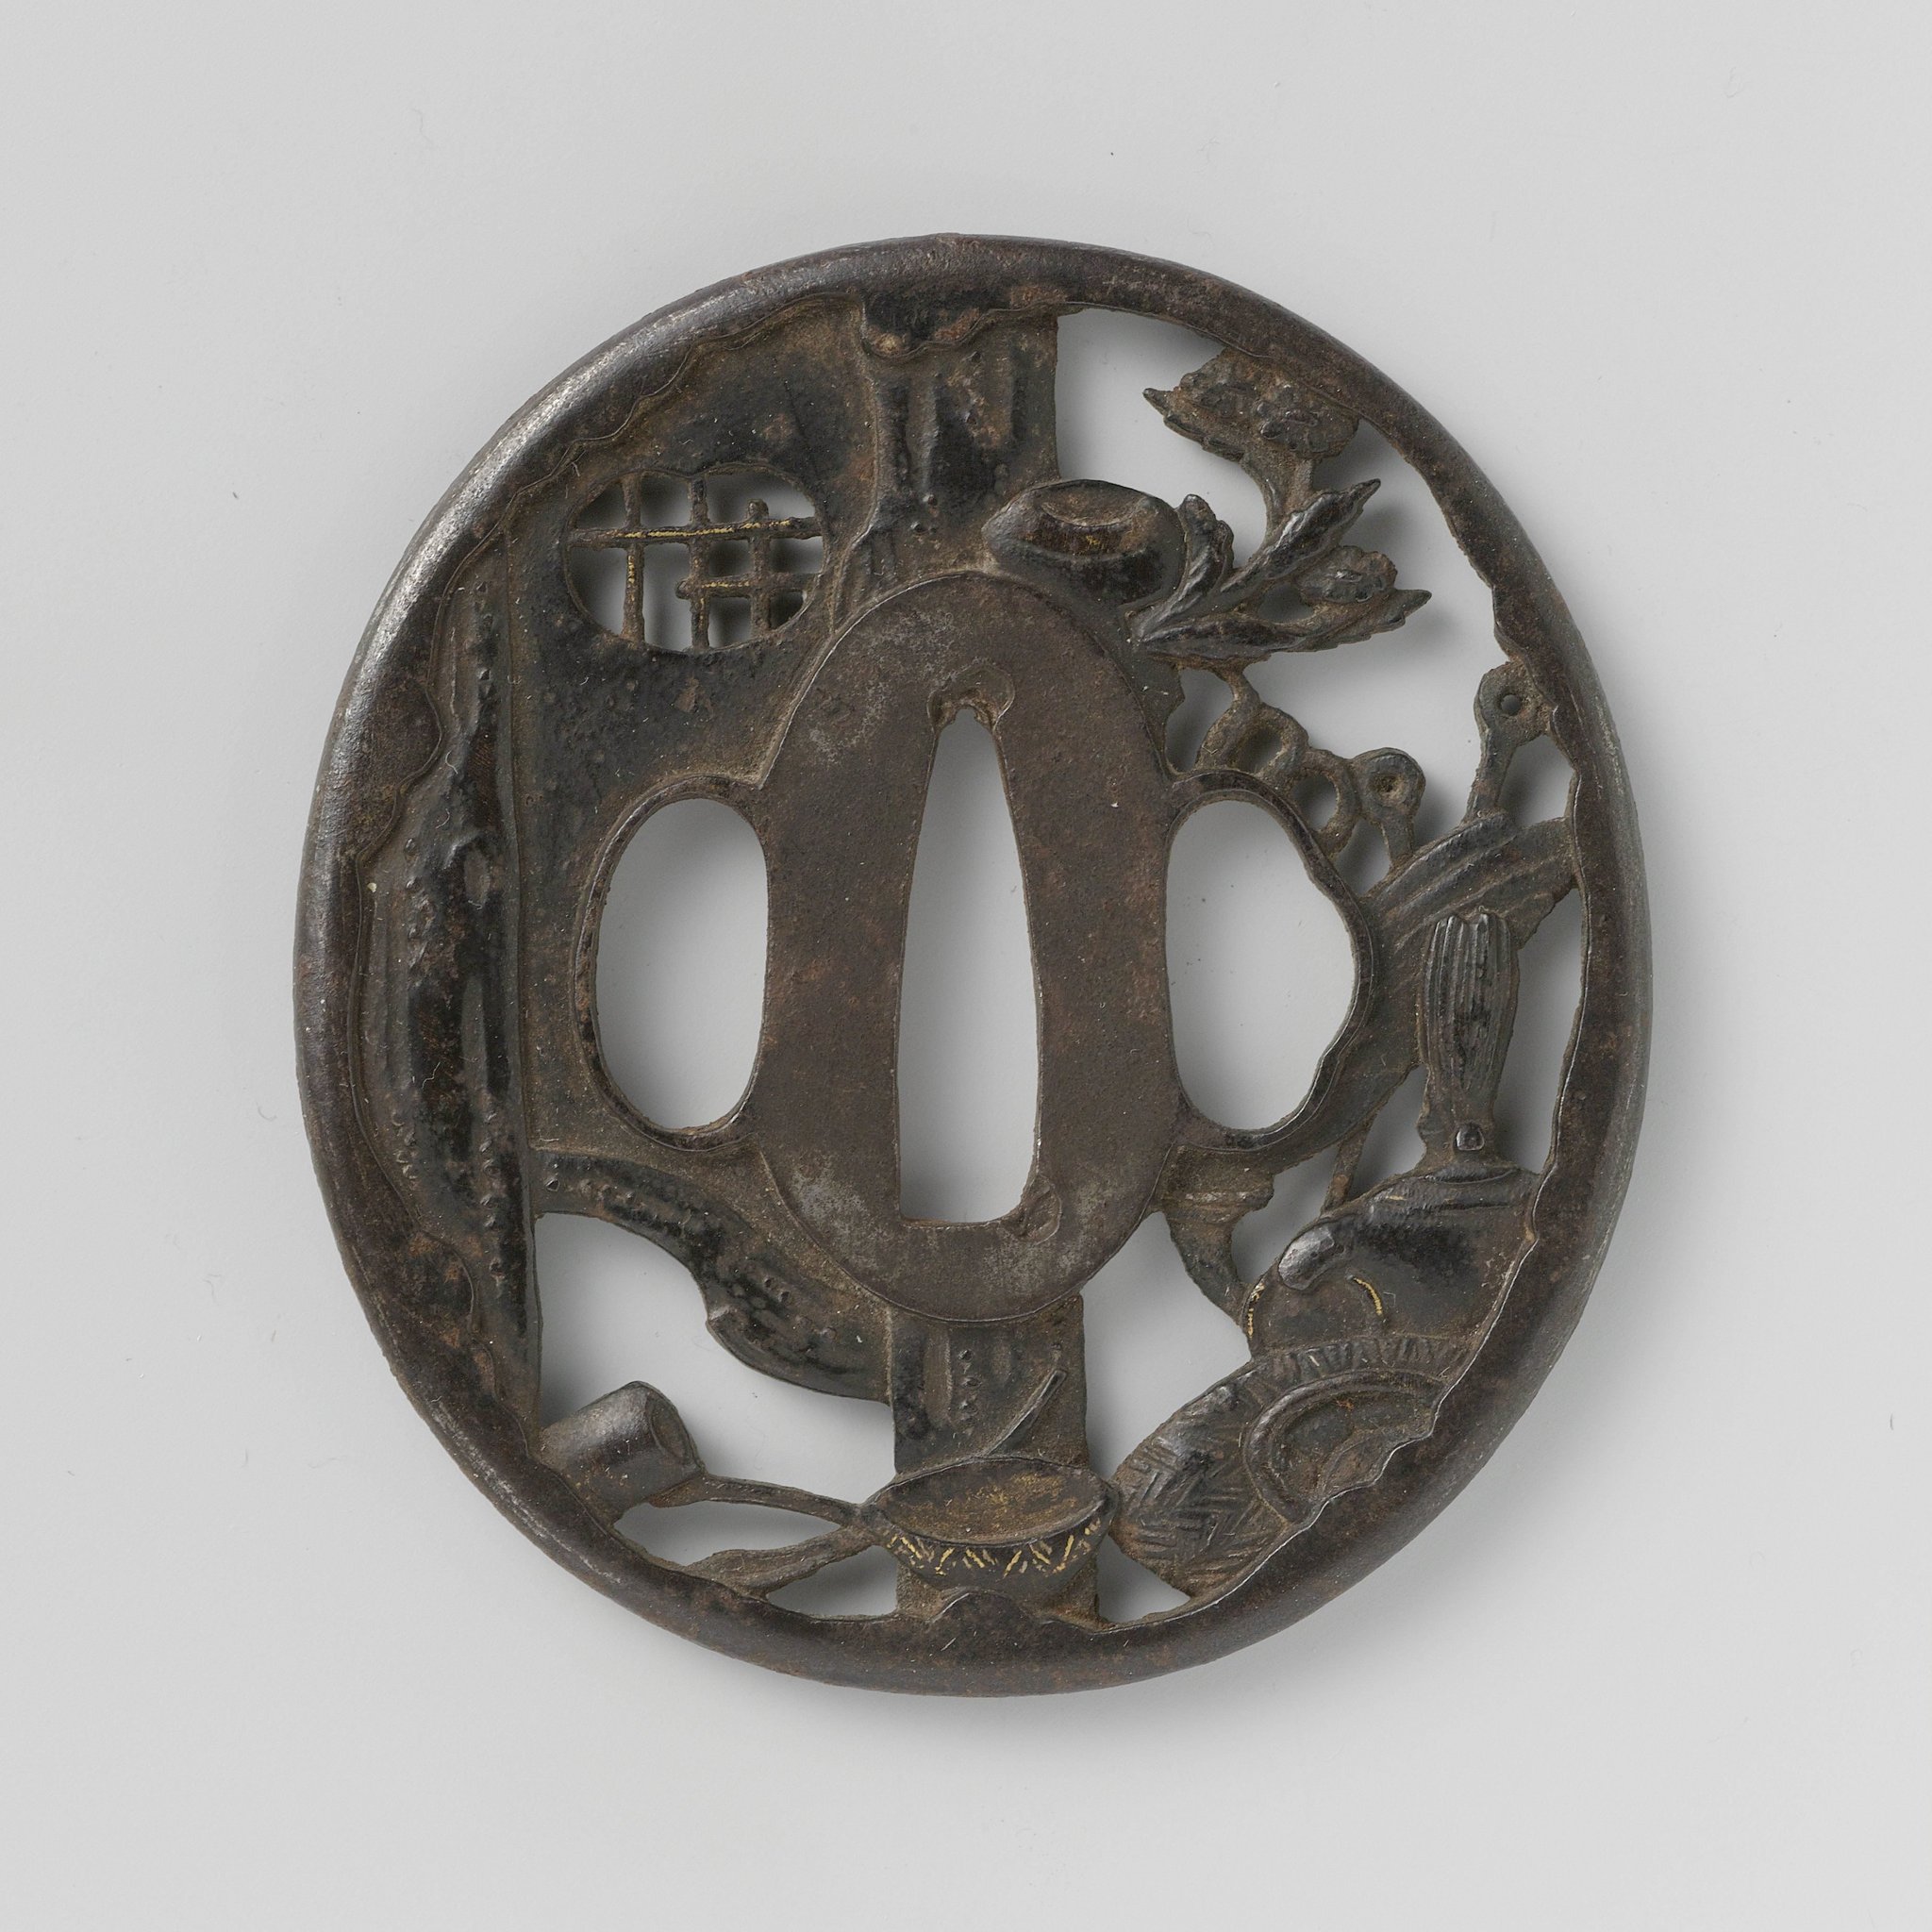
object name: tsuba, zwaardstootplaat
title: Hand guard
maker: Anonymous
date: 1800-1900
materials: gold, iron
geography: japan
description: Ovale tsuba met een theehut en attributen van de theeceremonie in positief silhouet en reliëf; details in goud nunome-zogan.